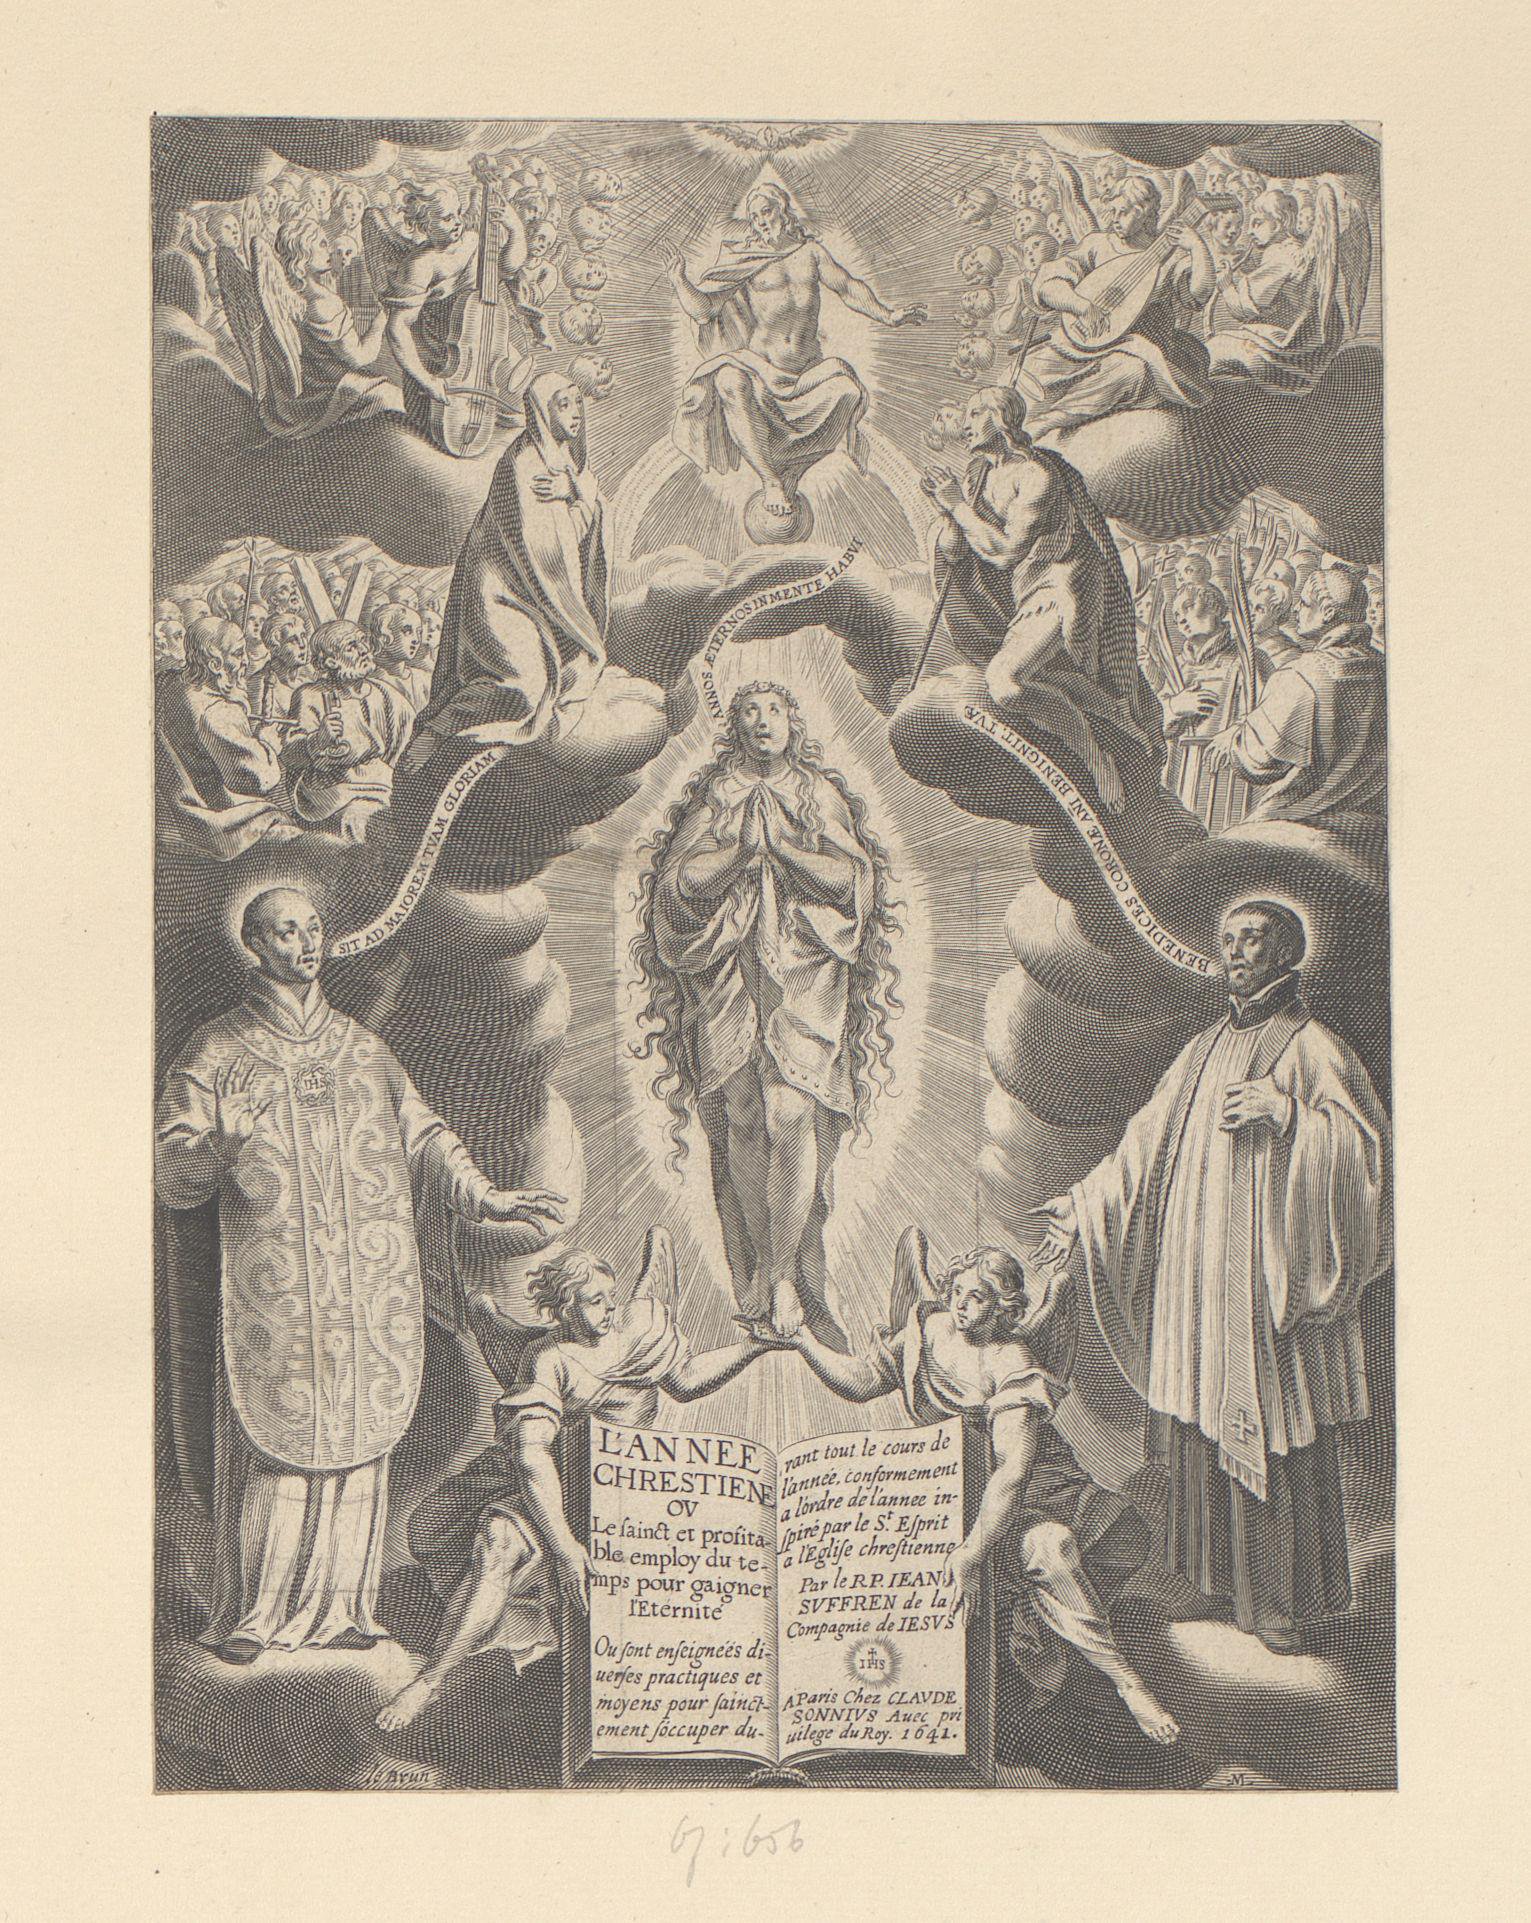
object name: album leaf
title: Werken van Charles le Brun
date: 1641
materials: paper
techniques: engraving, etching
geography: paris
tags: upright figures of mary without the christ-child, 'salvator mundi', making a blessing gesture; an orb in his hand or at his feet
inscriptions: date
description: Titelpagina uit: Suffren, Jean. L'année Chrestienne, ou le sainct et profitable employ du temps pour gaigner l'éternité. 2e druk. Parijs: Claude Sonnius, 1641.